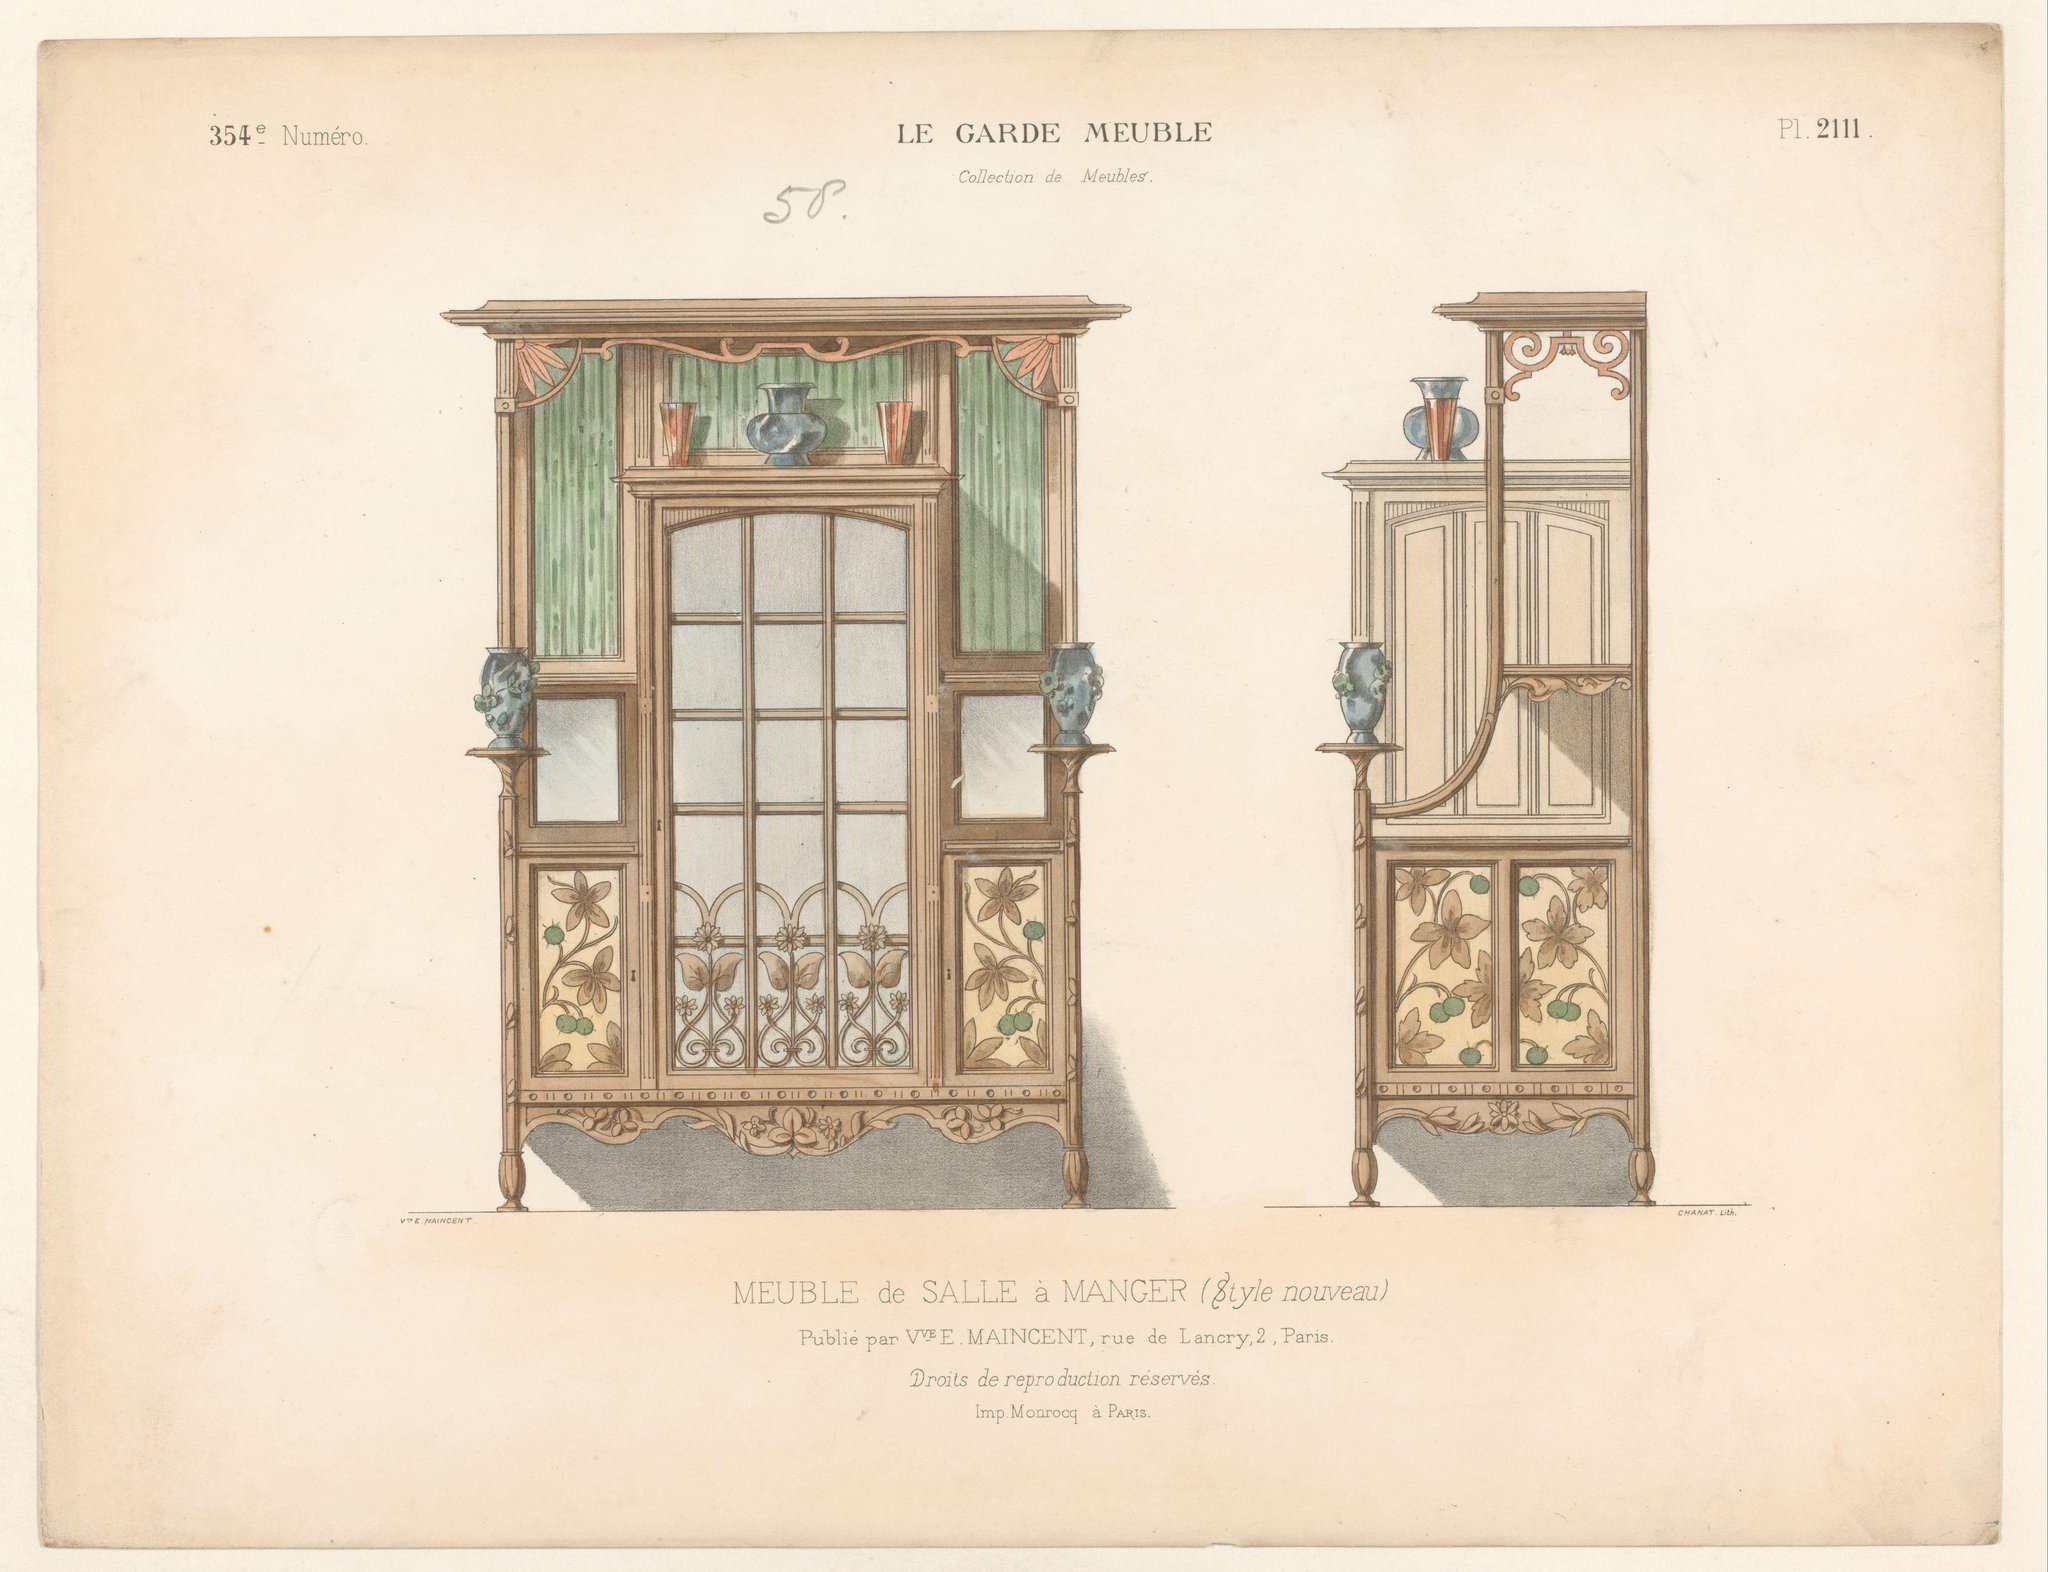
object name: print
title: Meuble de salle à manger (Style nouveau)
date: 1895-1935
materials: paper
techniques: hand coloring, lithograph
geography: paris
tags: furniture for storage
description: Ieder Livraison in de serie Le Garde-Meuble bevat negen platen: drie 'sièges' (zitmeubels), drie 'meubles' (diverse meubels zoals tafels en kasten) en drie 'tentures' (gordijnen en draperieën).